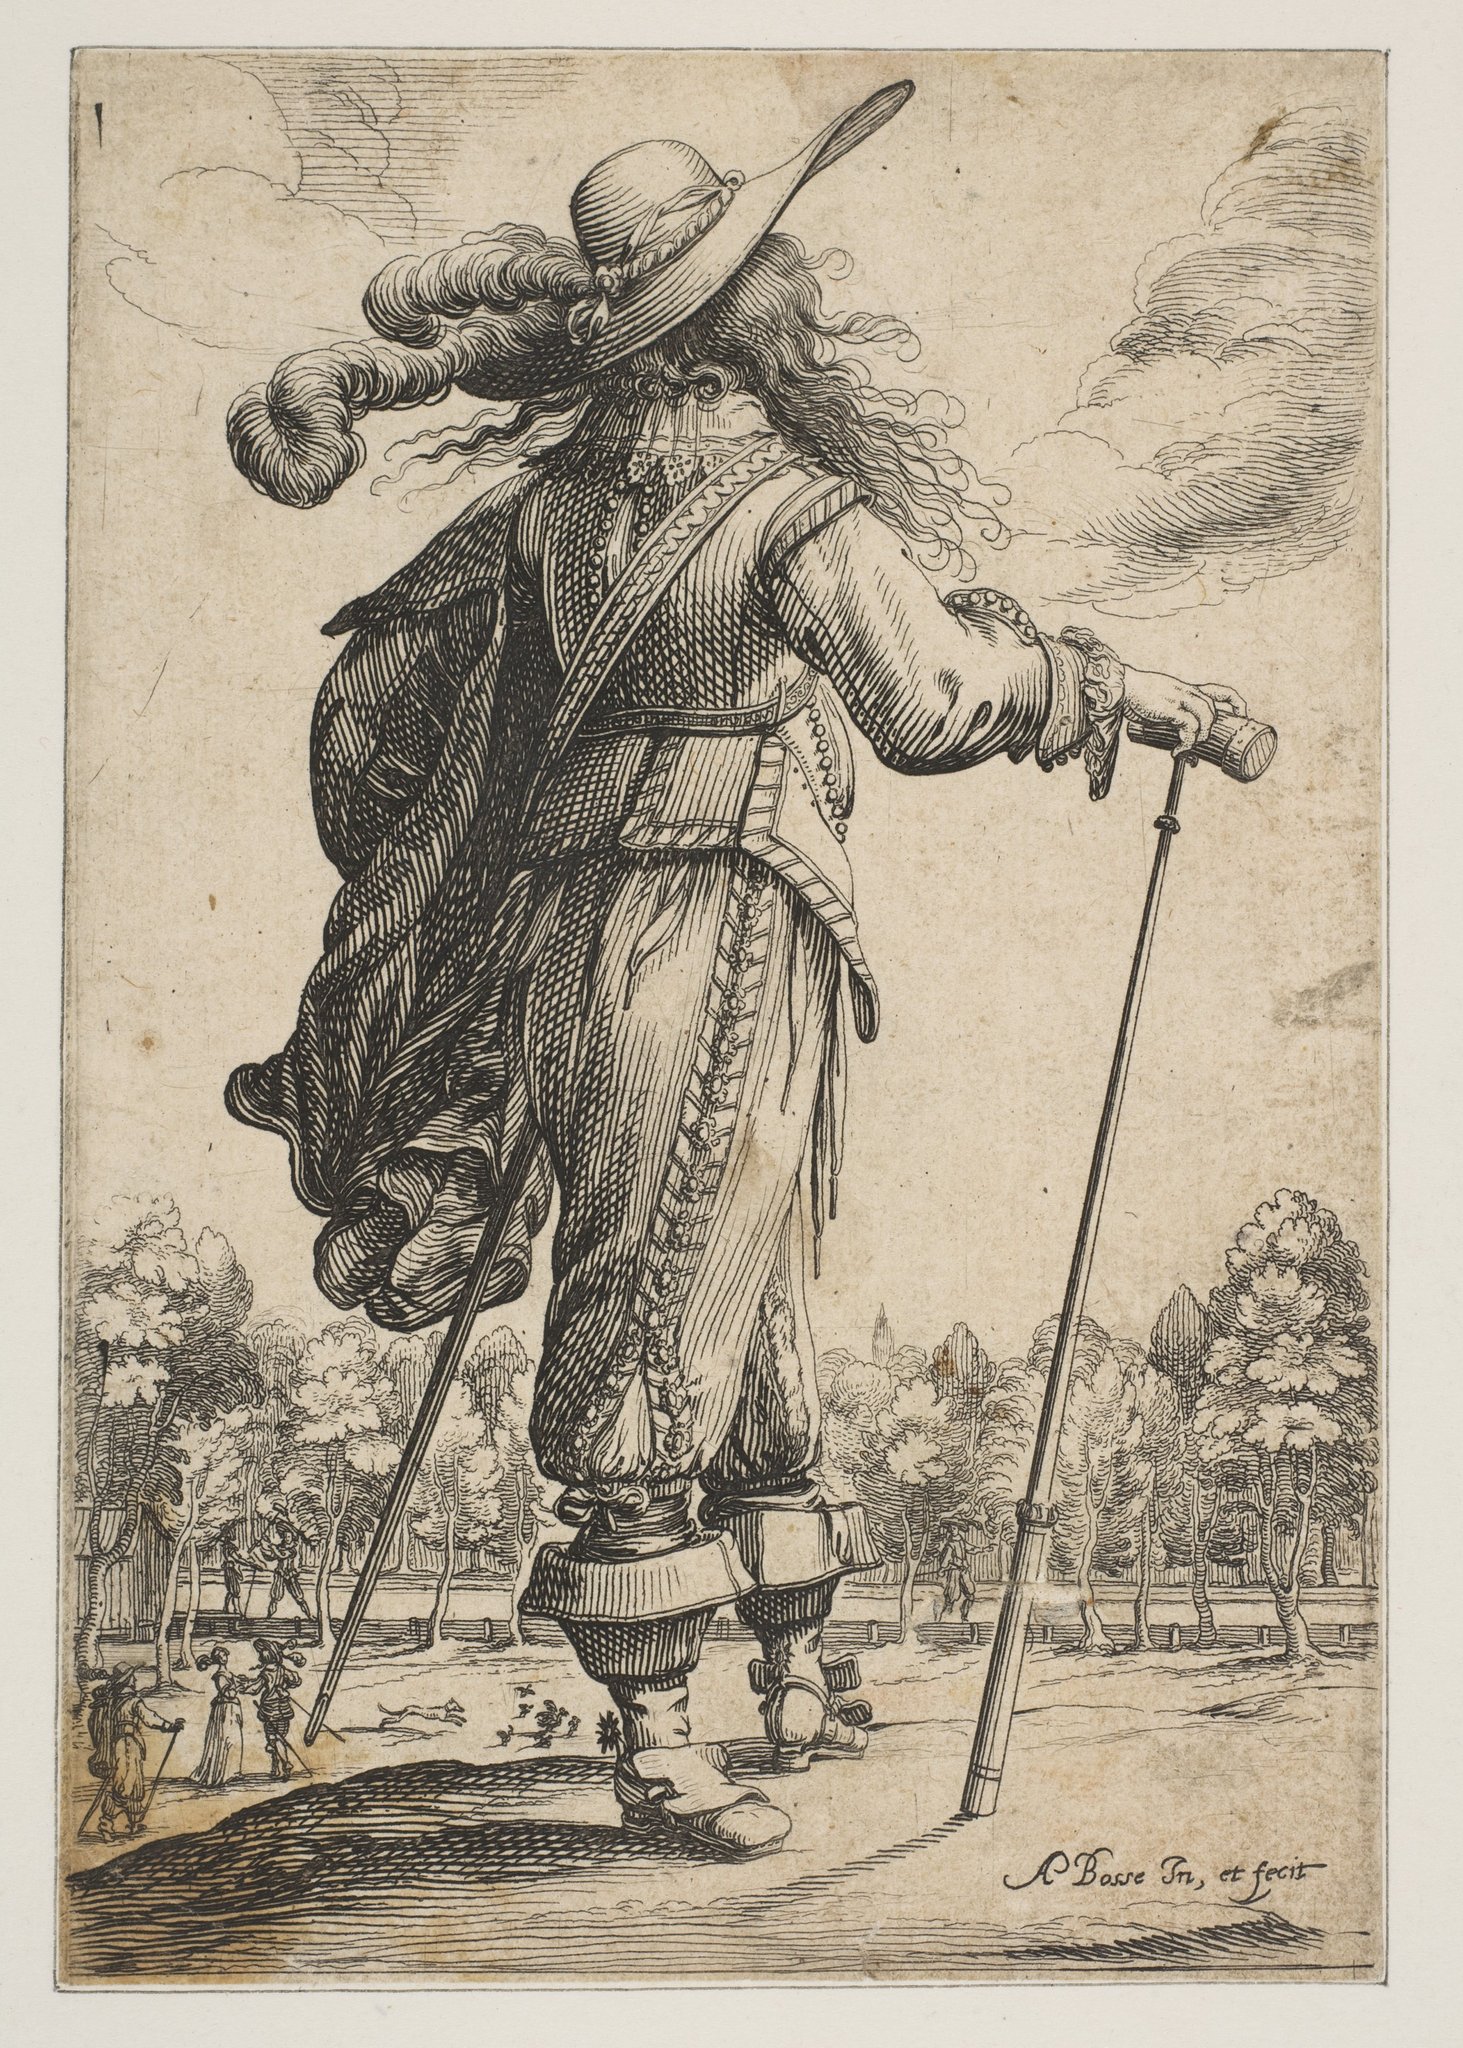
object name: print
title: A Man Seen from the Back Leaning on a Croquet Mallet (Le Jouer de mail)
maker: abraham bosse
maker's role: artist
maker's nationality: french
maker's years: 1602-1676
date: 1629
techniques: etching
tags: men,trees